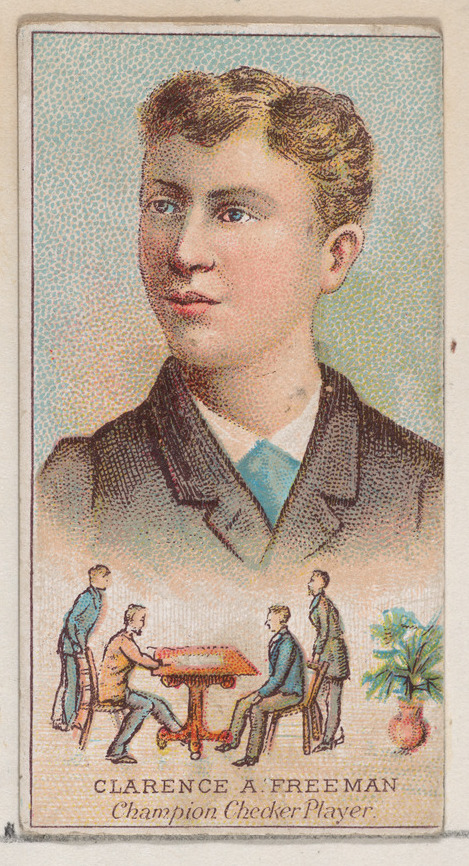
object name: print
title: Clarence A. Freeman, Champion Checker Player, Champion Oarsman of the World, from the Champions of Games and Sports series (N184, Type 2) issued by W.S. Kimball & Co.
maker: w.s. kimball & co.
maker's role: publisher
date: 1887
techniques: color lithograph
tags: men,games